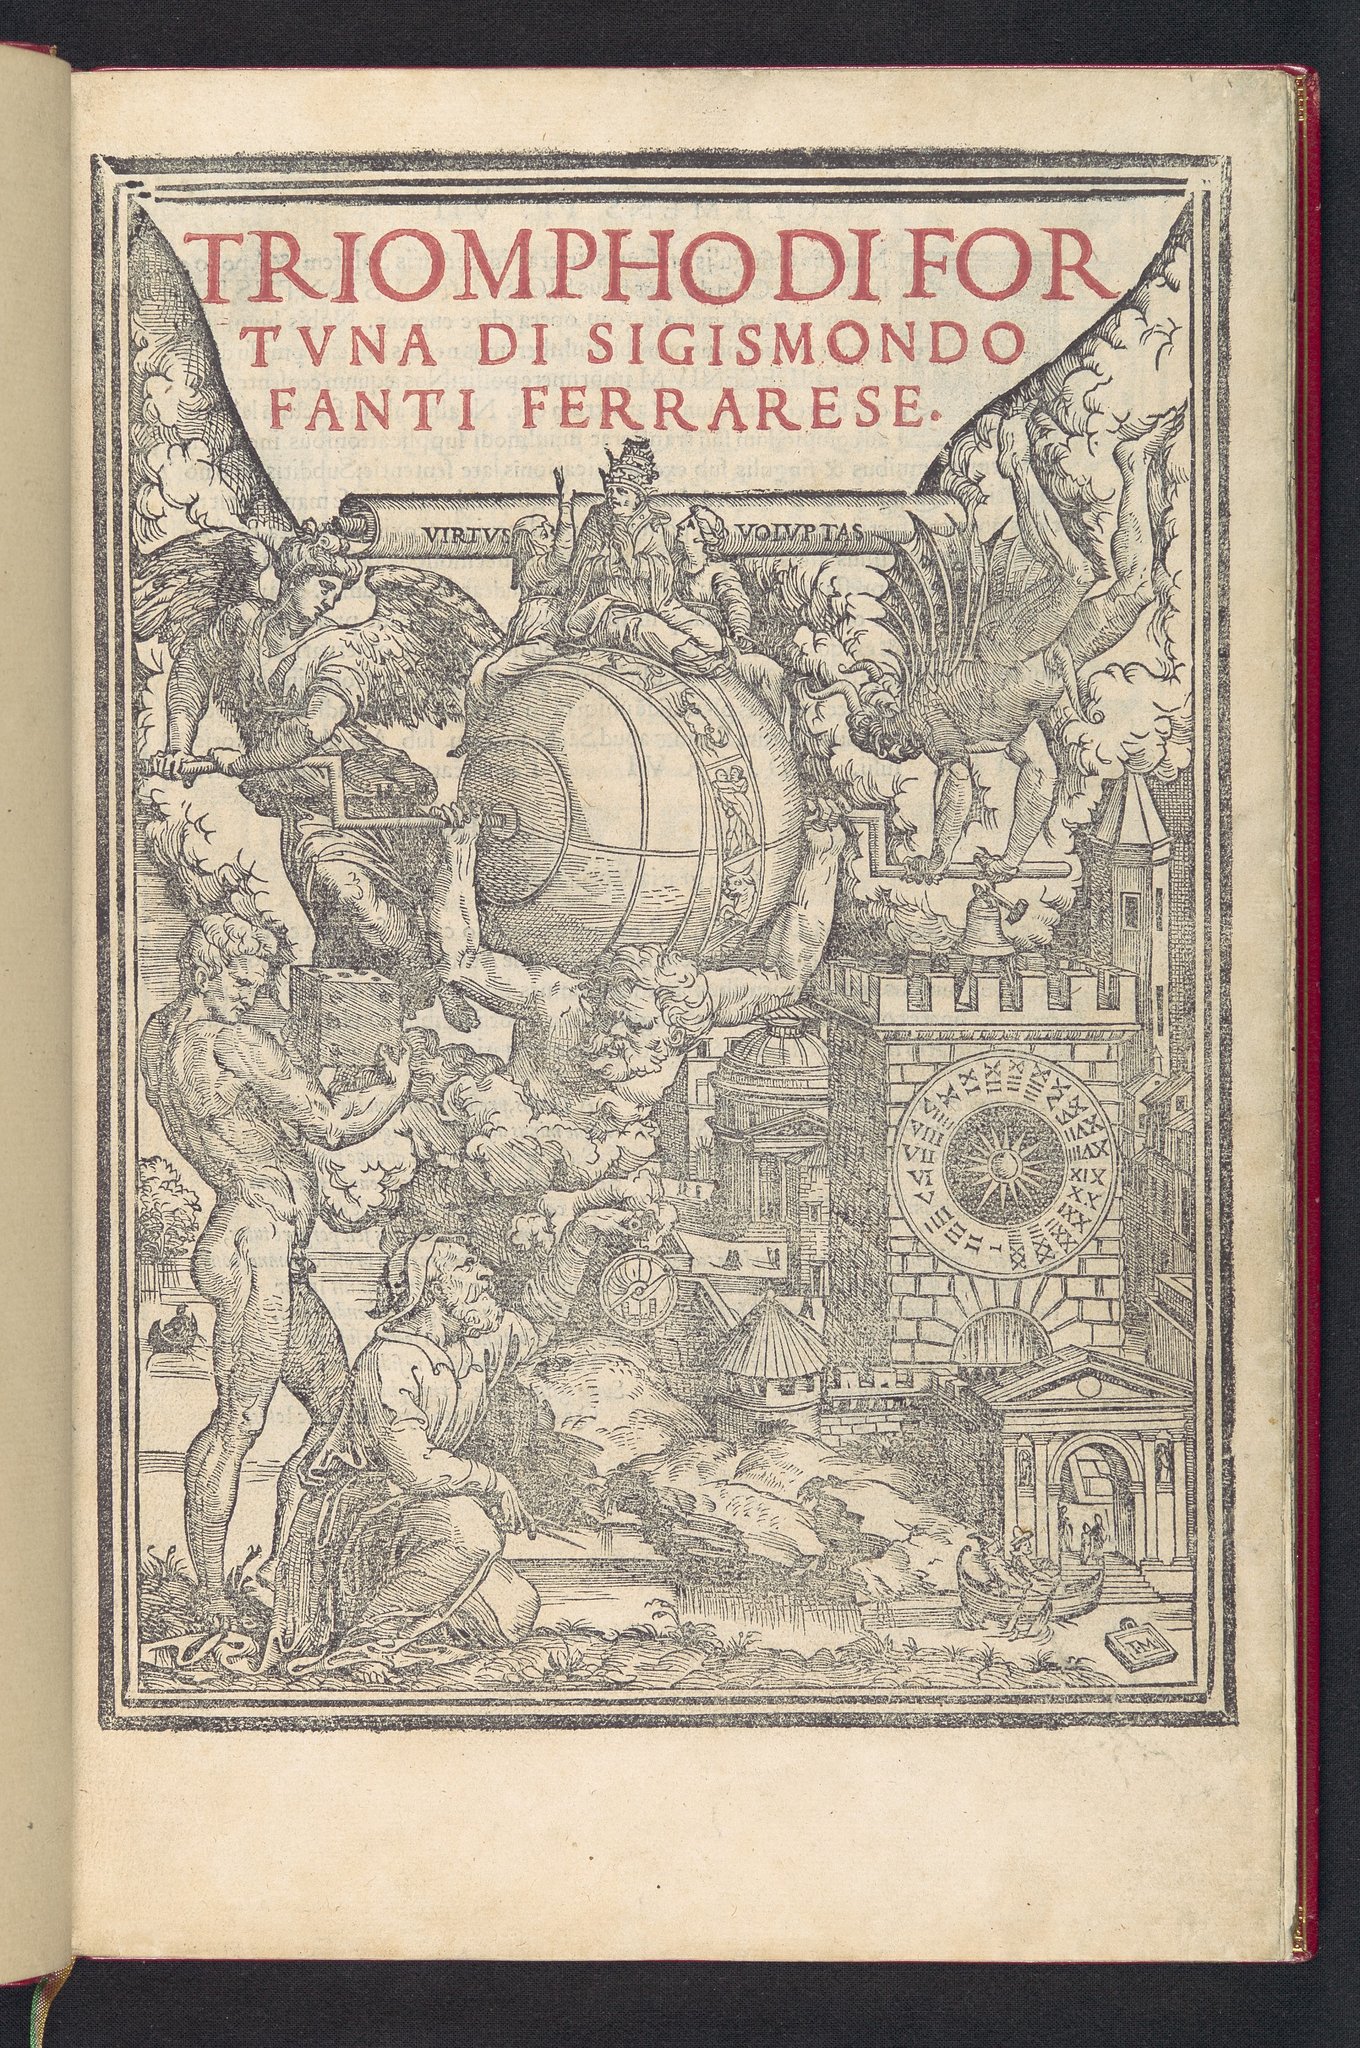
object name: book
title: Triompho di Fortuna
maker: sigismundo fanti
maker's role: author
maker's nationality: italian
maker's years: 1500-1550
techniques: printing, woodcut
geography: italy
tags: male nudes,dice,angels,devil,astronomy